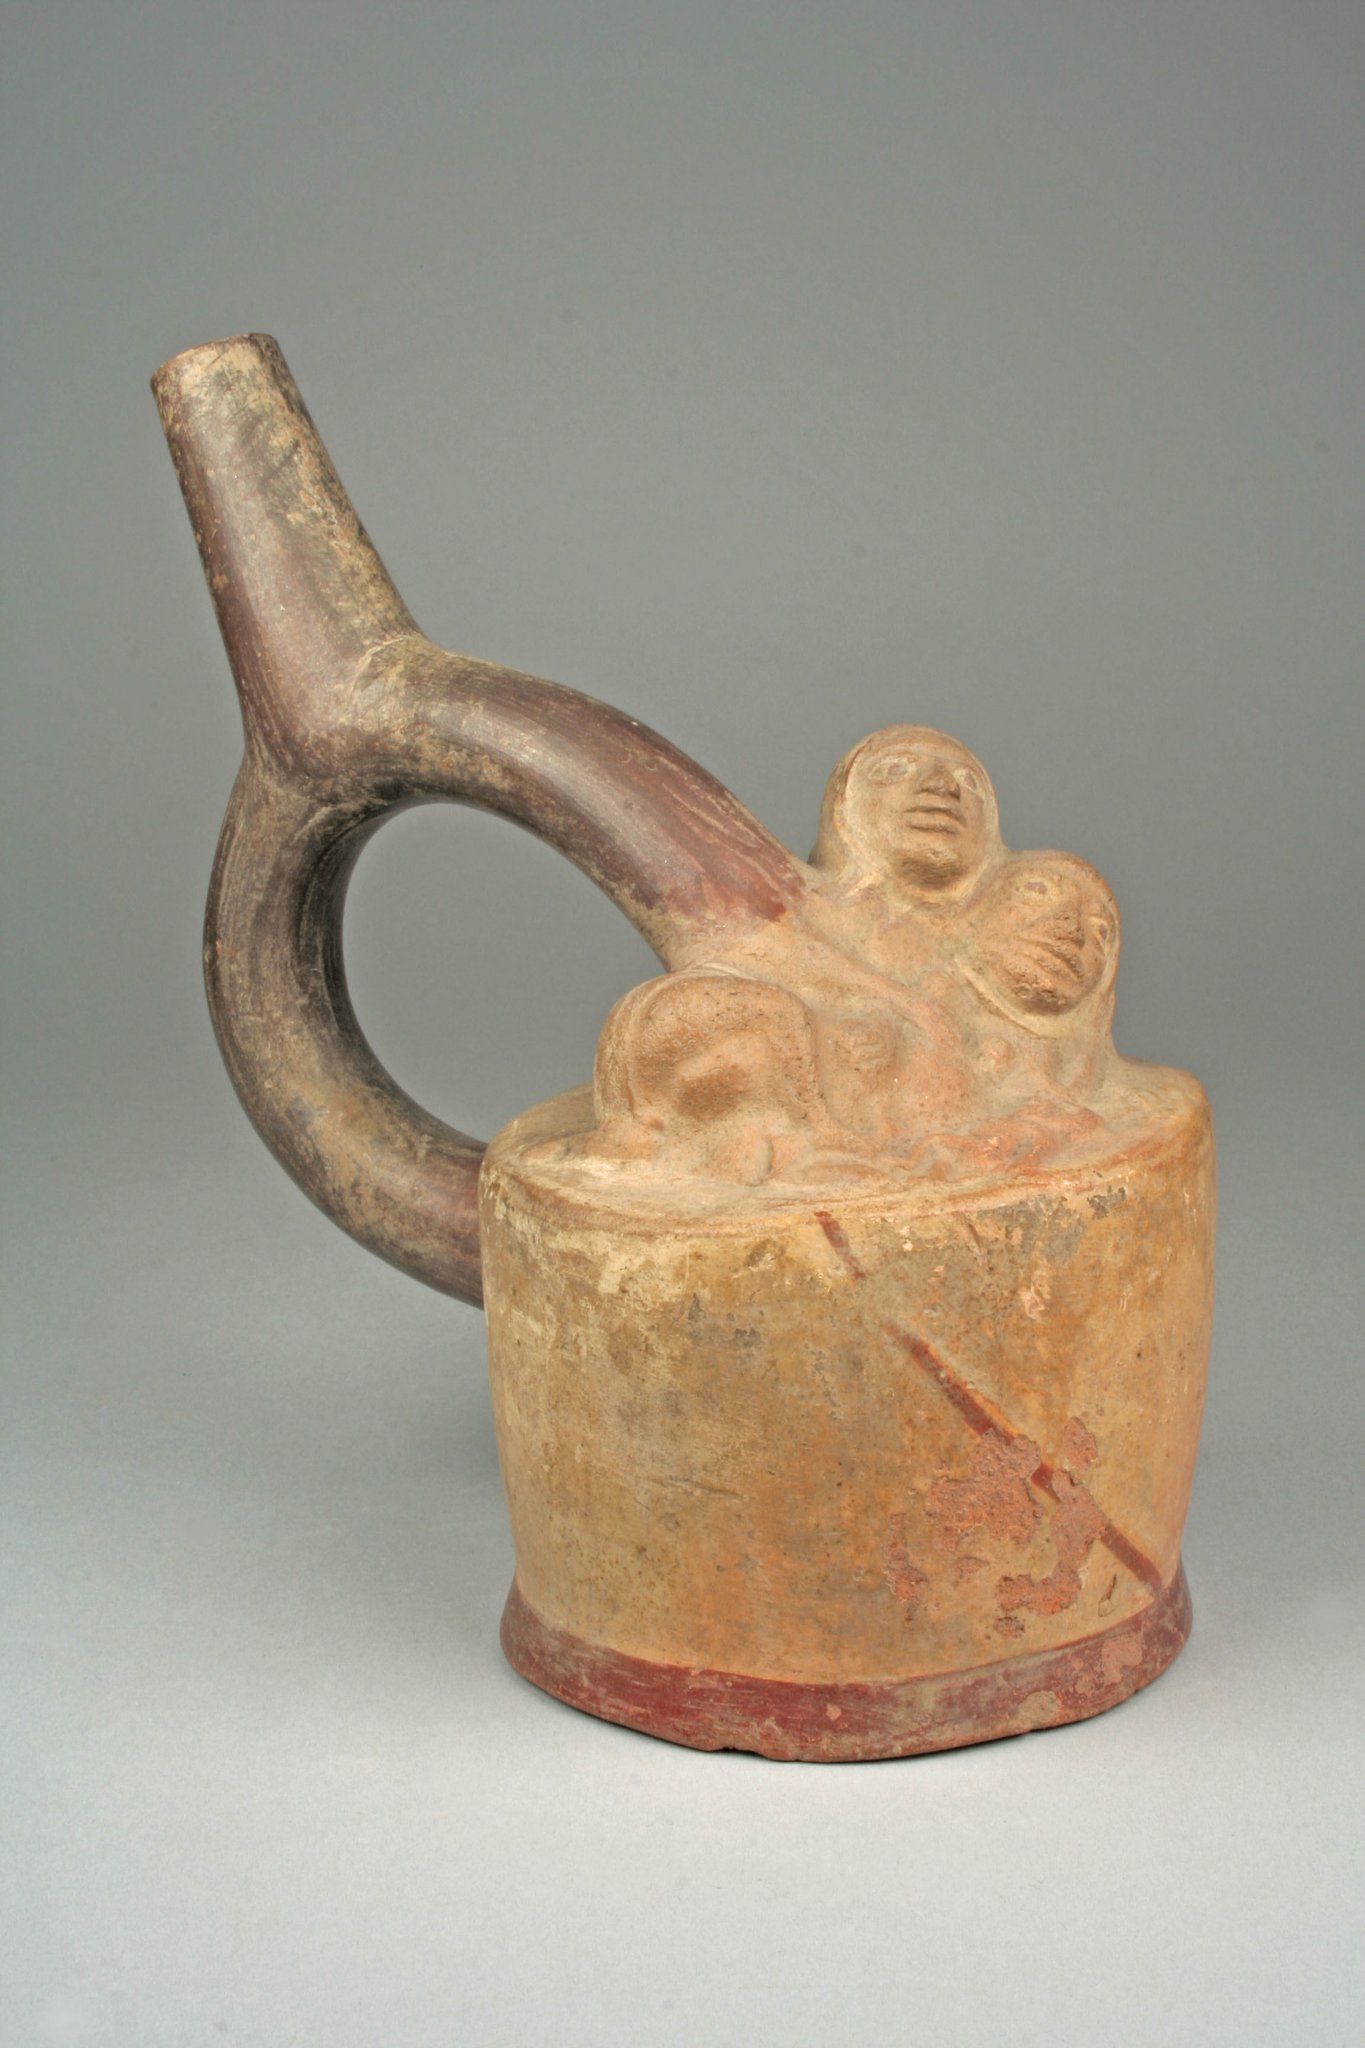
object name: bottle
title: Stirrup Spout Bottle with Figures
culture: moche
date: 301-700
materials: ceramic, pigment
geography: peru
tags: heads